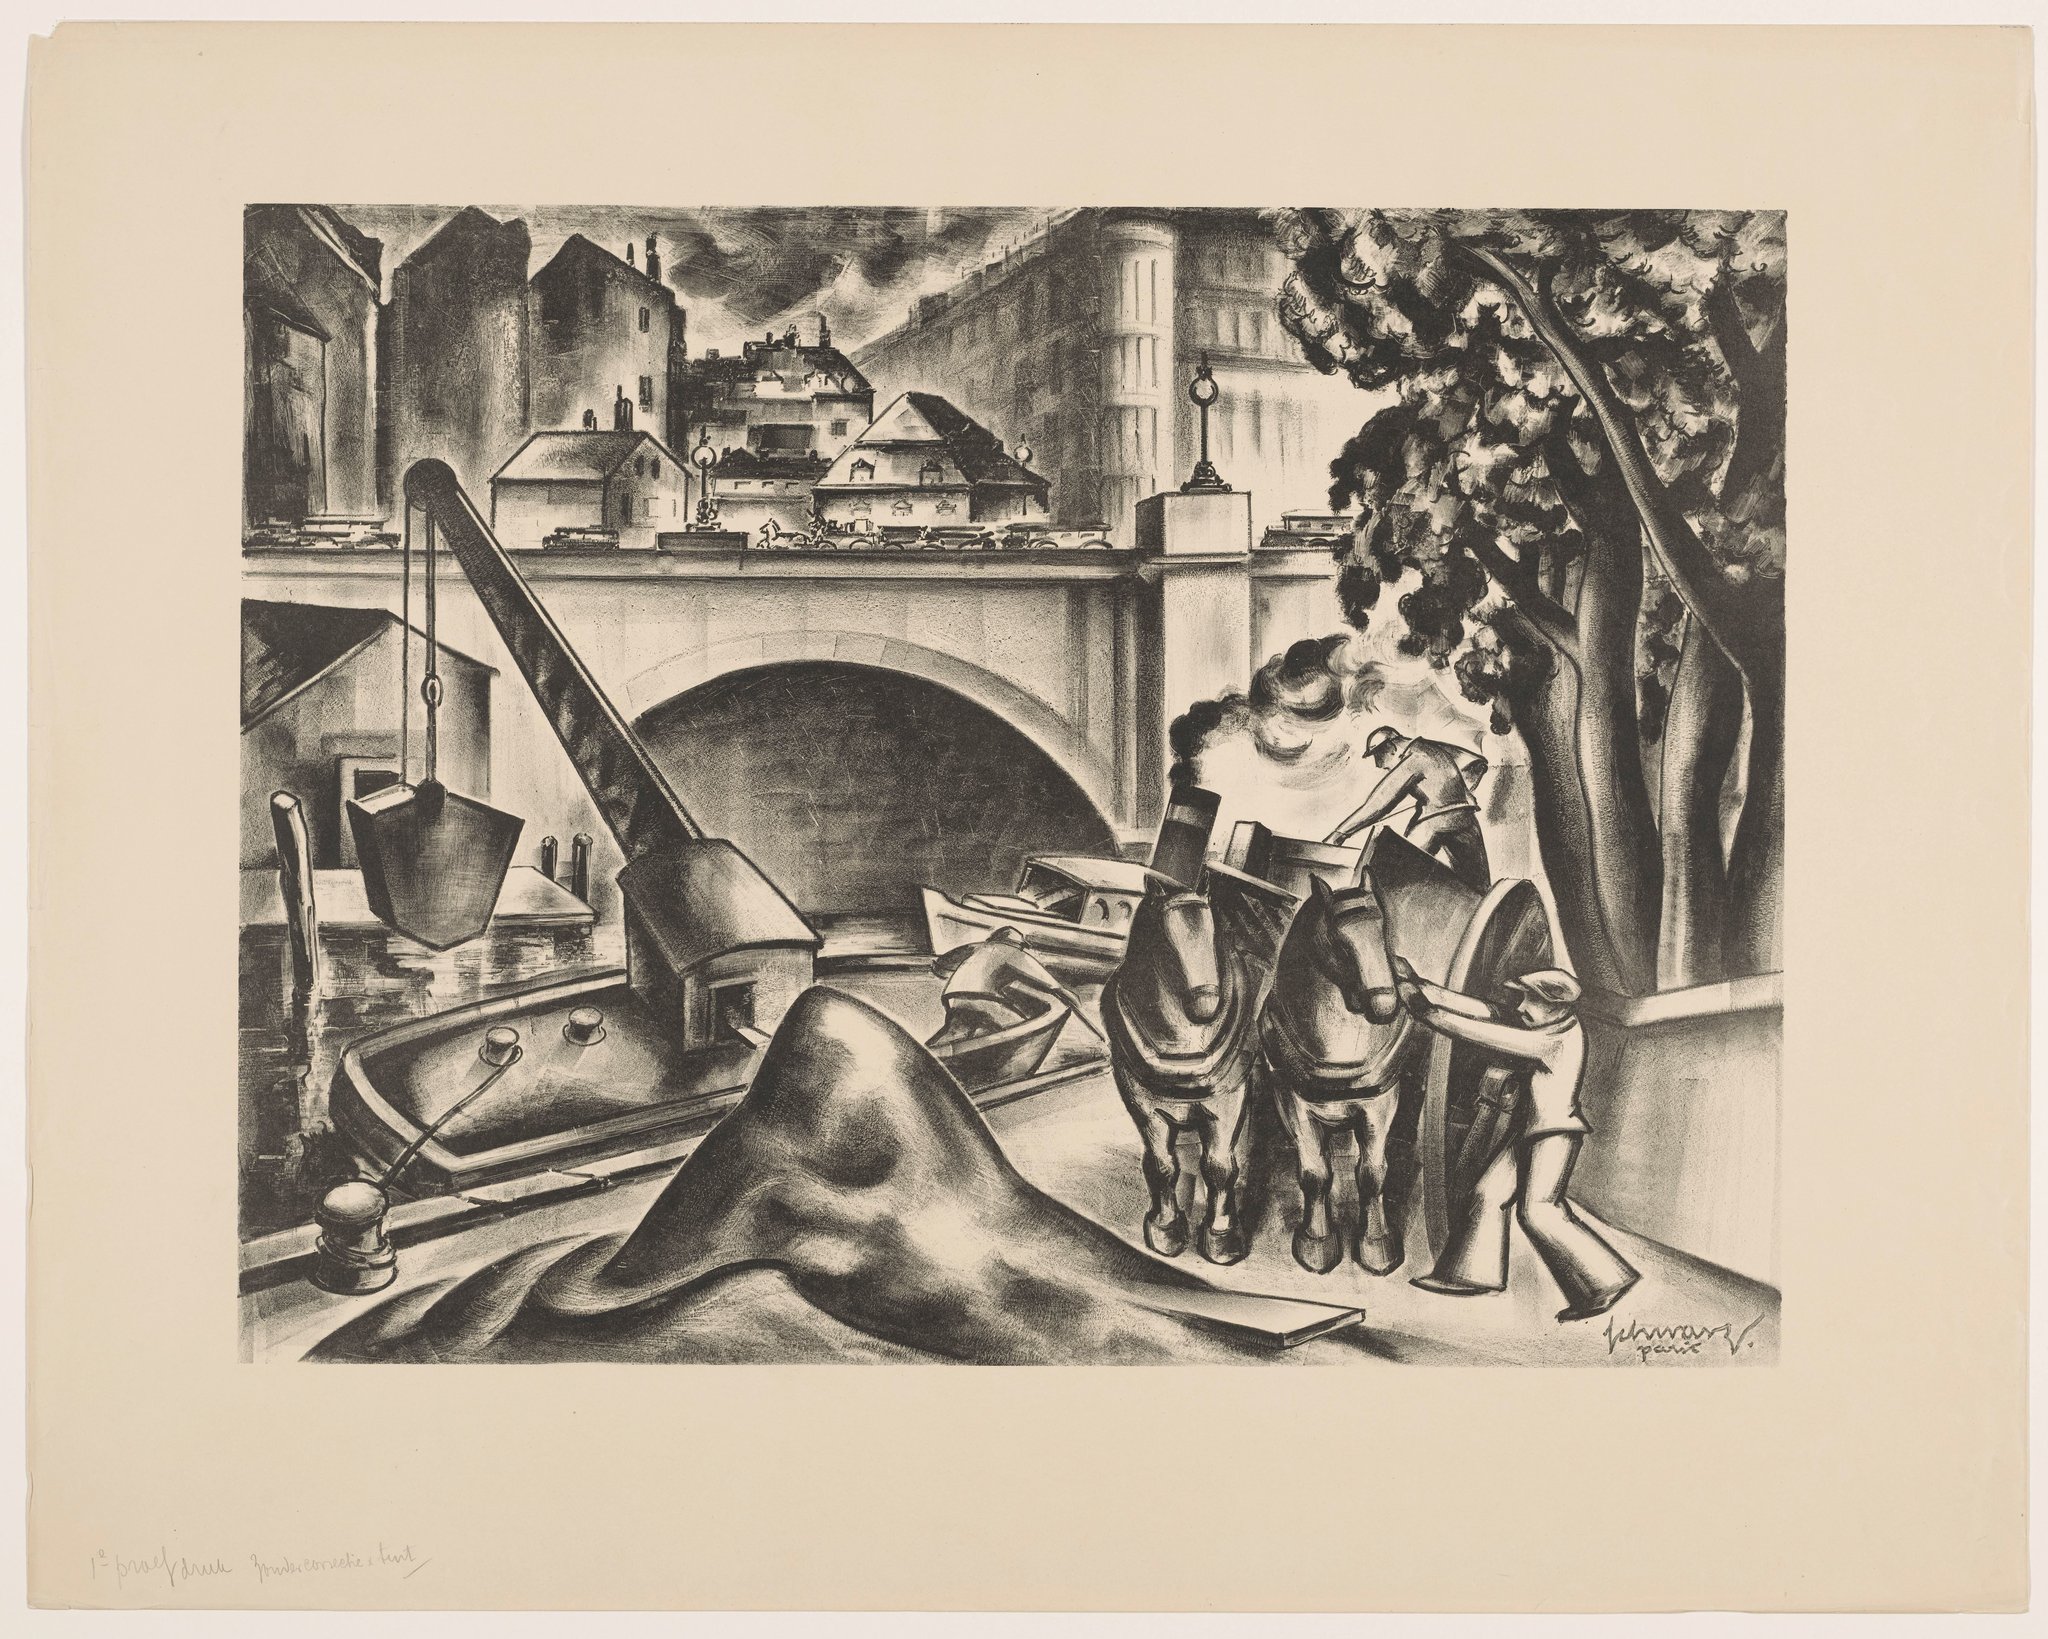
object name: print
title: Kade van de Seine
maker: mommie schwarz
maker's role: print maker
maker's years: 1876-1942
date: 1909-1910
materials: paper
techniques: lithograph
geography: paris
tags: trees, horse, bridge in city across river, canal, etc., paris